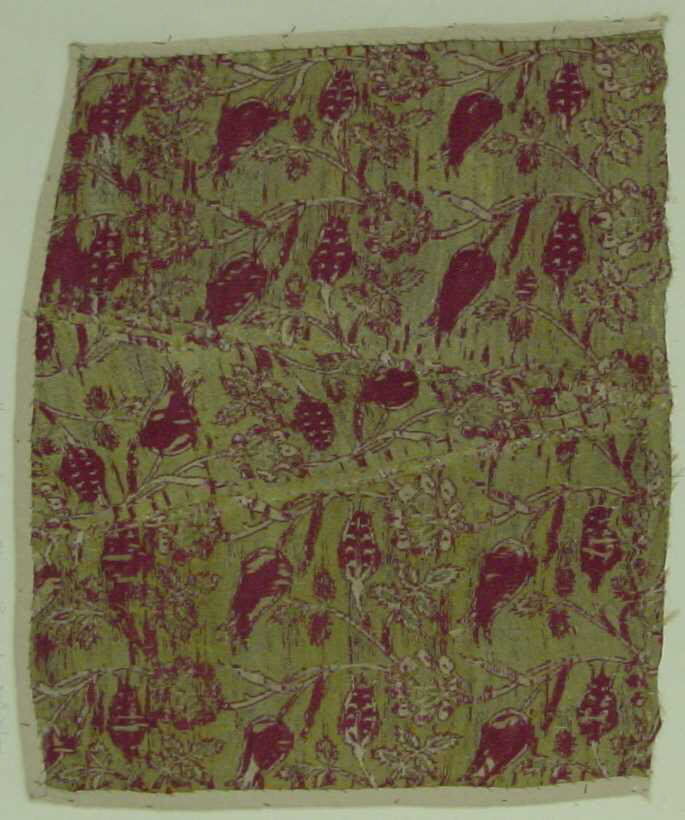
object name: textile fragment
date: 1501-1600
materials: metal thread, silk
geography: turkey